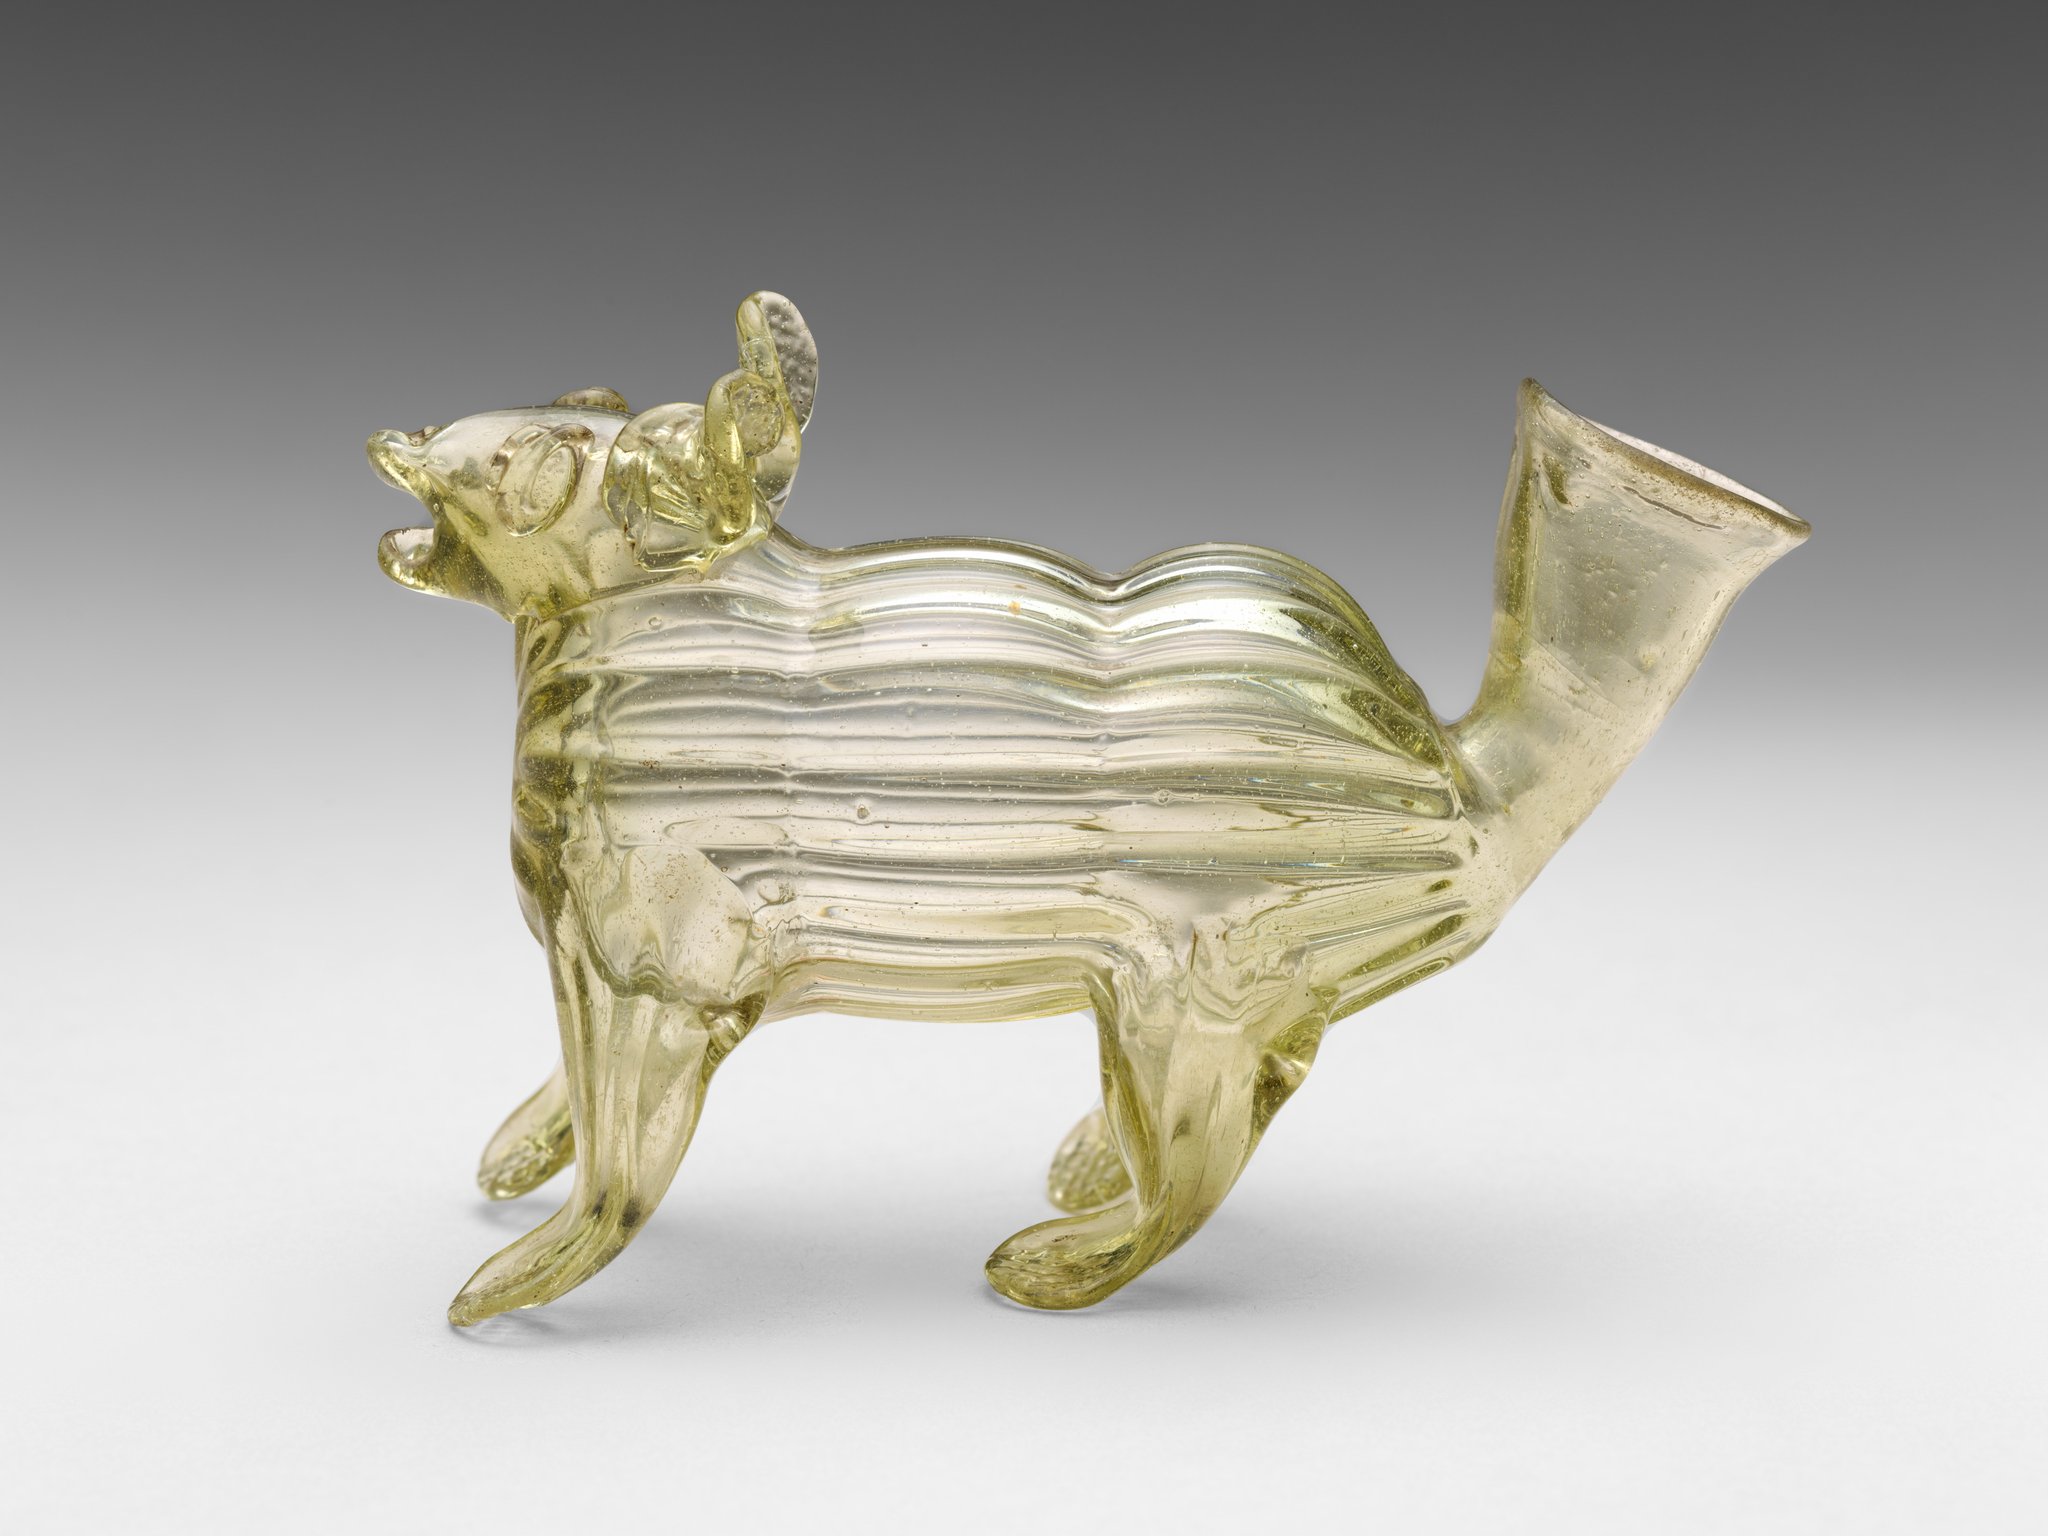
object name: oil lamp or bottle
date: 1601-1800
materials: glass